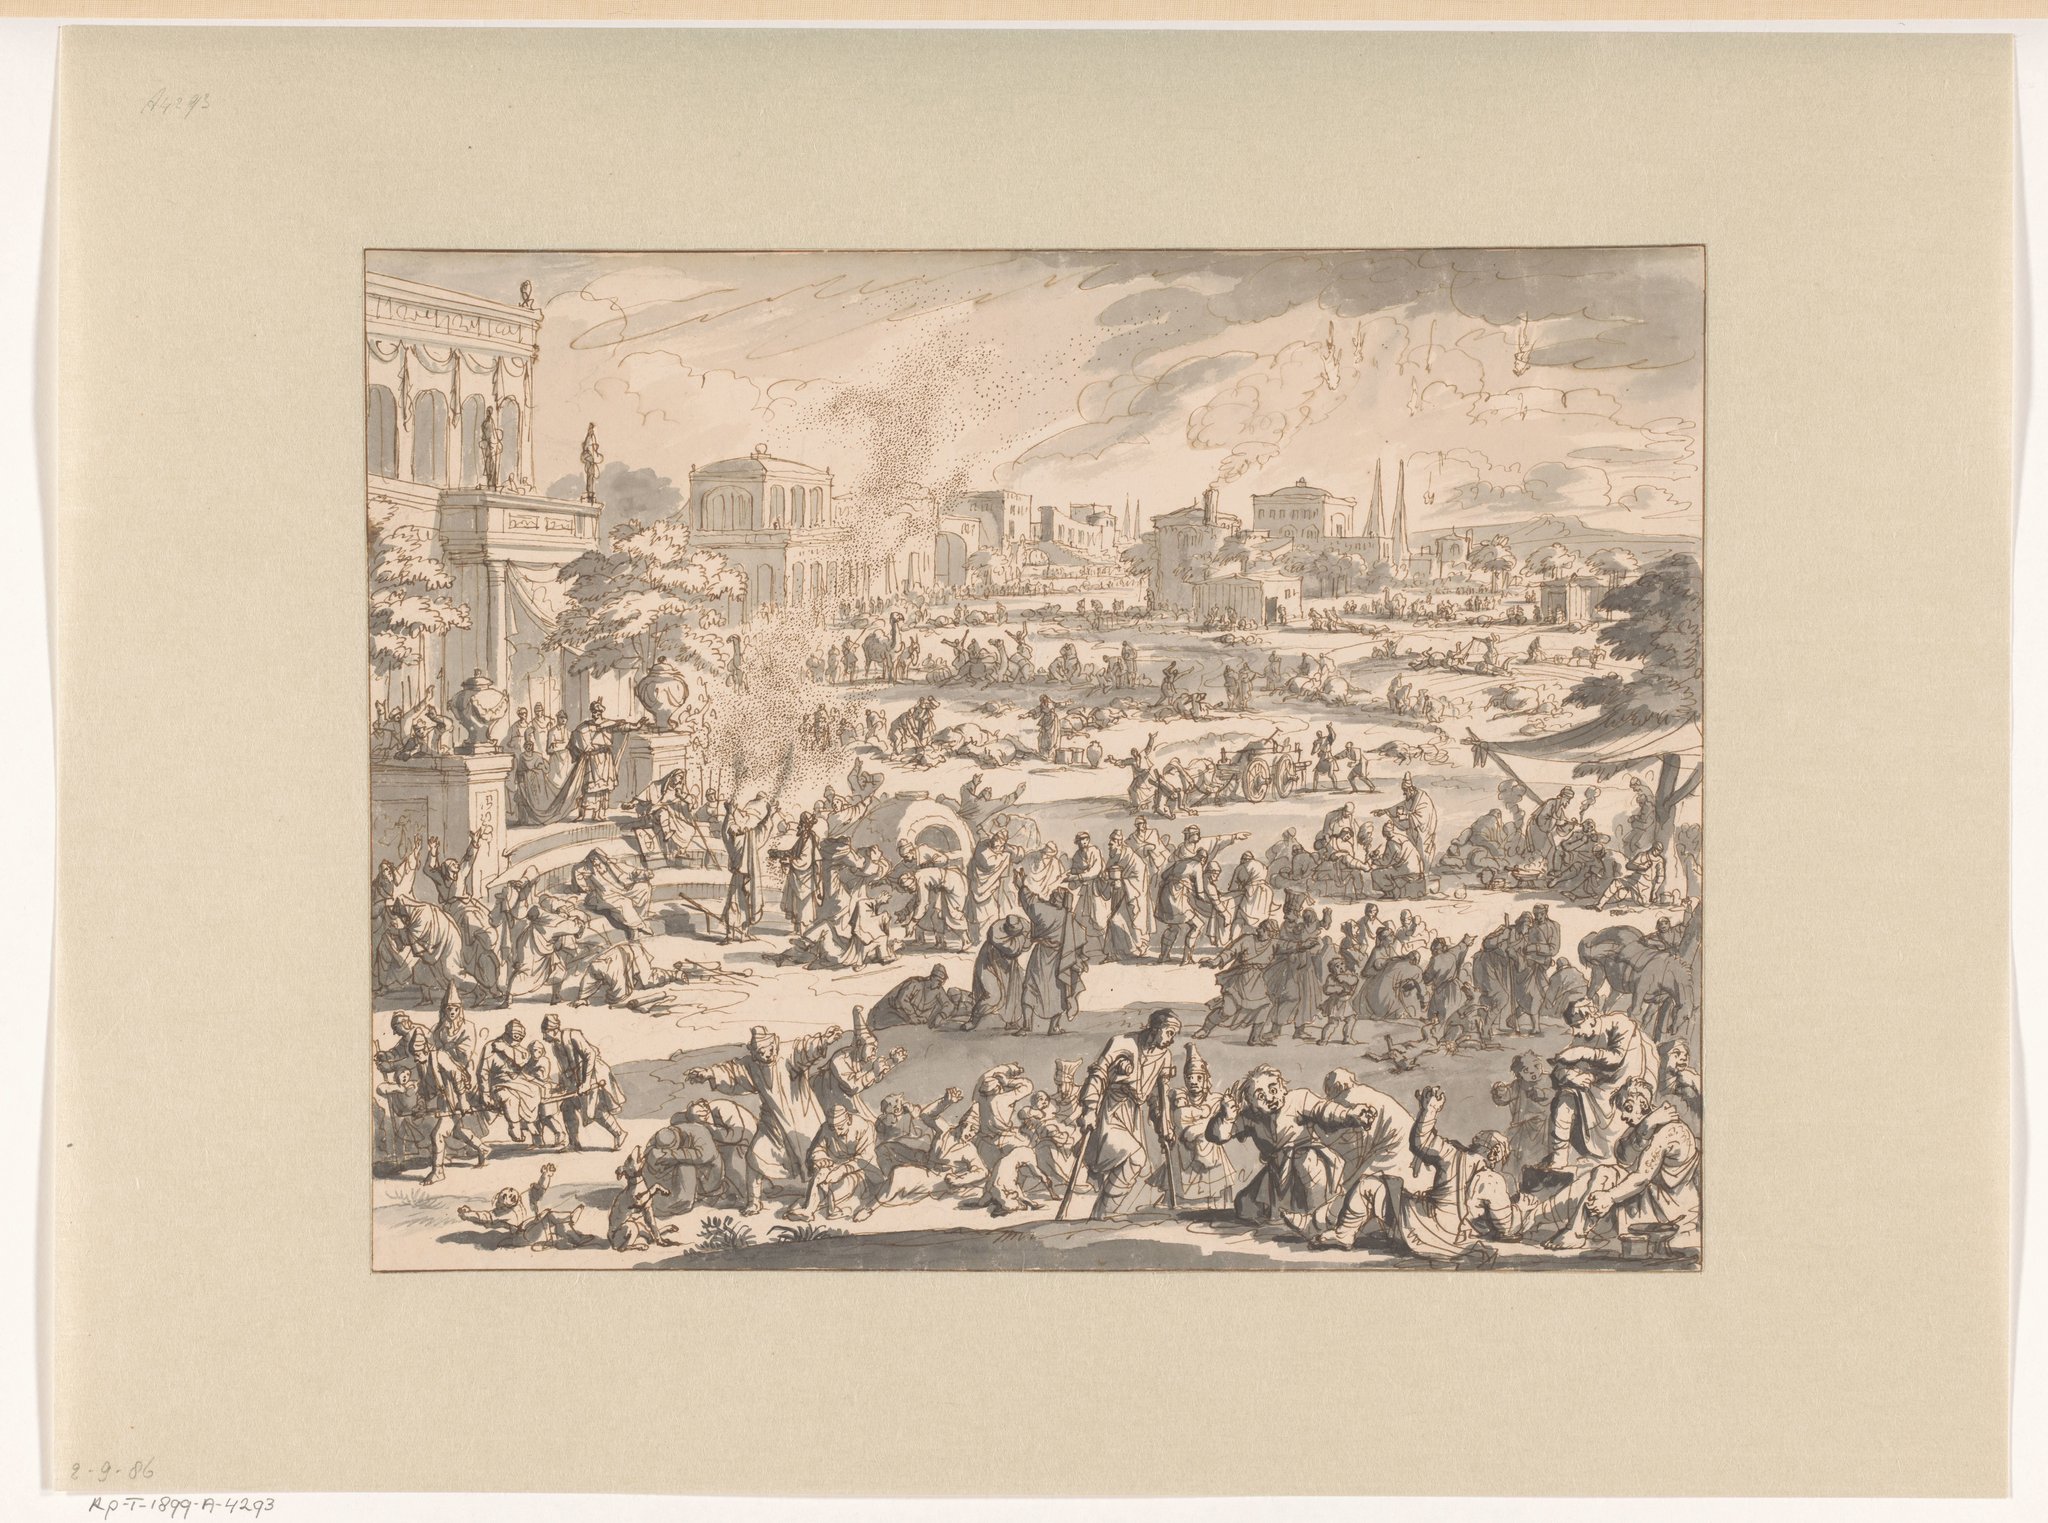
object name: drawing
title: Mozes en Aäron roepen plagen af over de Egyptenaren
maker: jan luyken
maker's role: draughtsman, print maker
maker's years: 1649-1712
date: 1659-1712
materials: ink, paper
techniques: brush, pen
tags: the plague of flies which fill the houses of the egyptians, the plague of murrain in cattle: all the animals of the egyptians die, the plague of boils: moses throws a handful of ashes into the air in front of pharaoh and it produces boils on the people and the animals